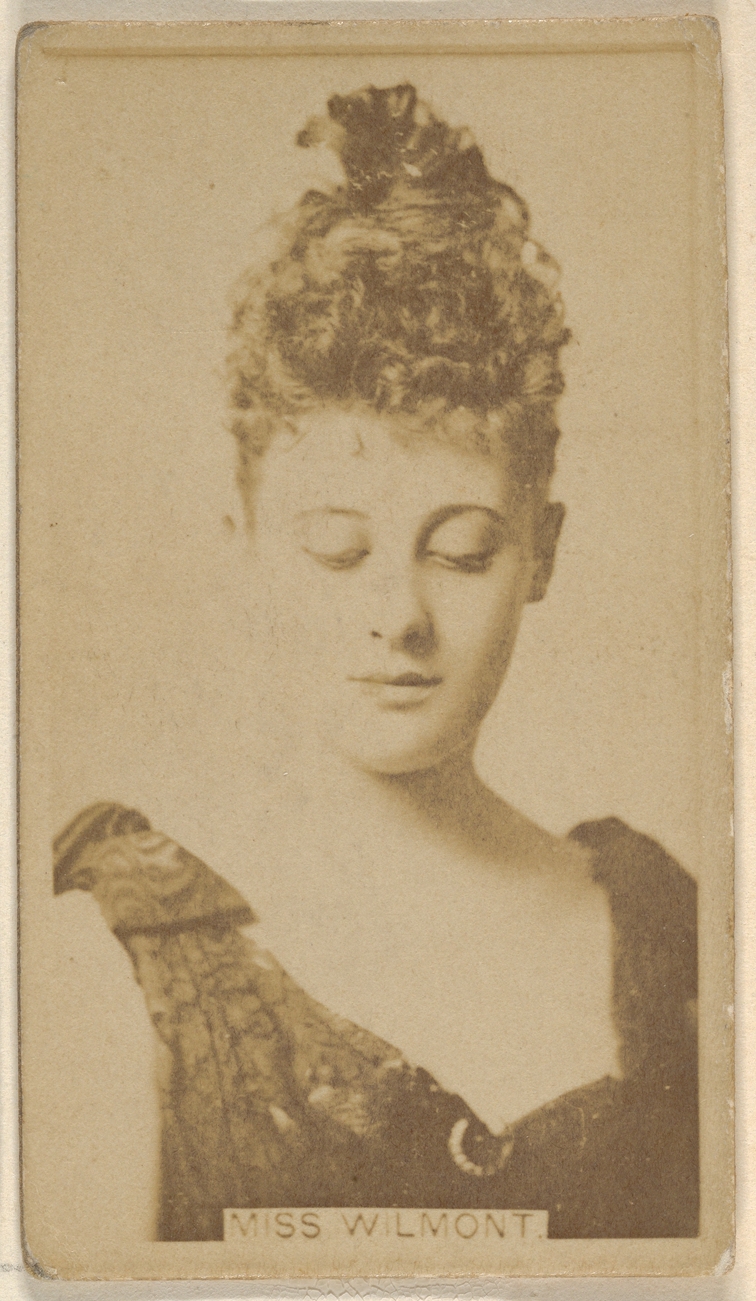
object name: photograph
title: Miss Wilmont, from the Actors and Actresses series (N45, Type 8) for Virginia Brights Cigarettes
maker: allen & ginter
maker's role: publisher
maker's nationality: american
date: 1888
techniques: albumen silver print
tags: portraits,women,actresses